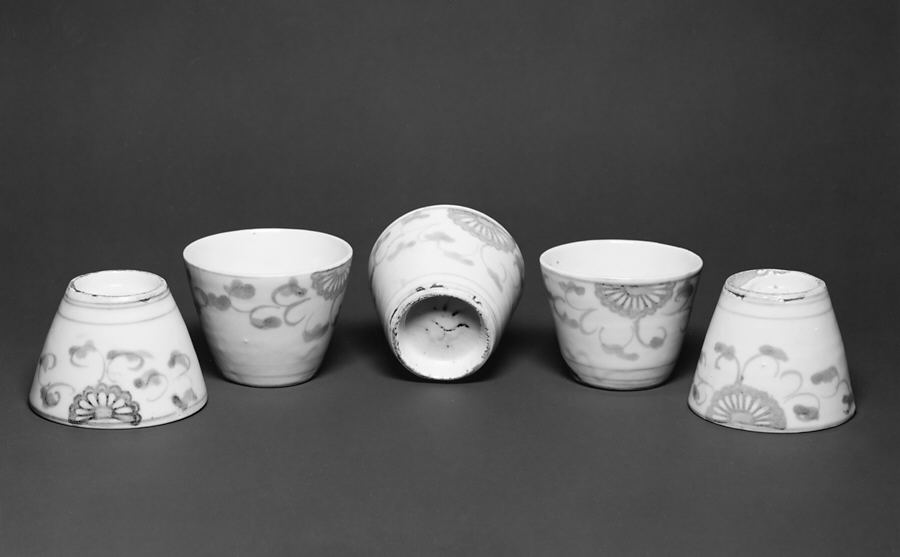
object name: soba cup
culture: japanese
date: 1801-1900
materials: cobalt, porcelain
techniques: painting, underglaze